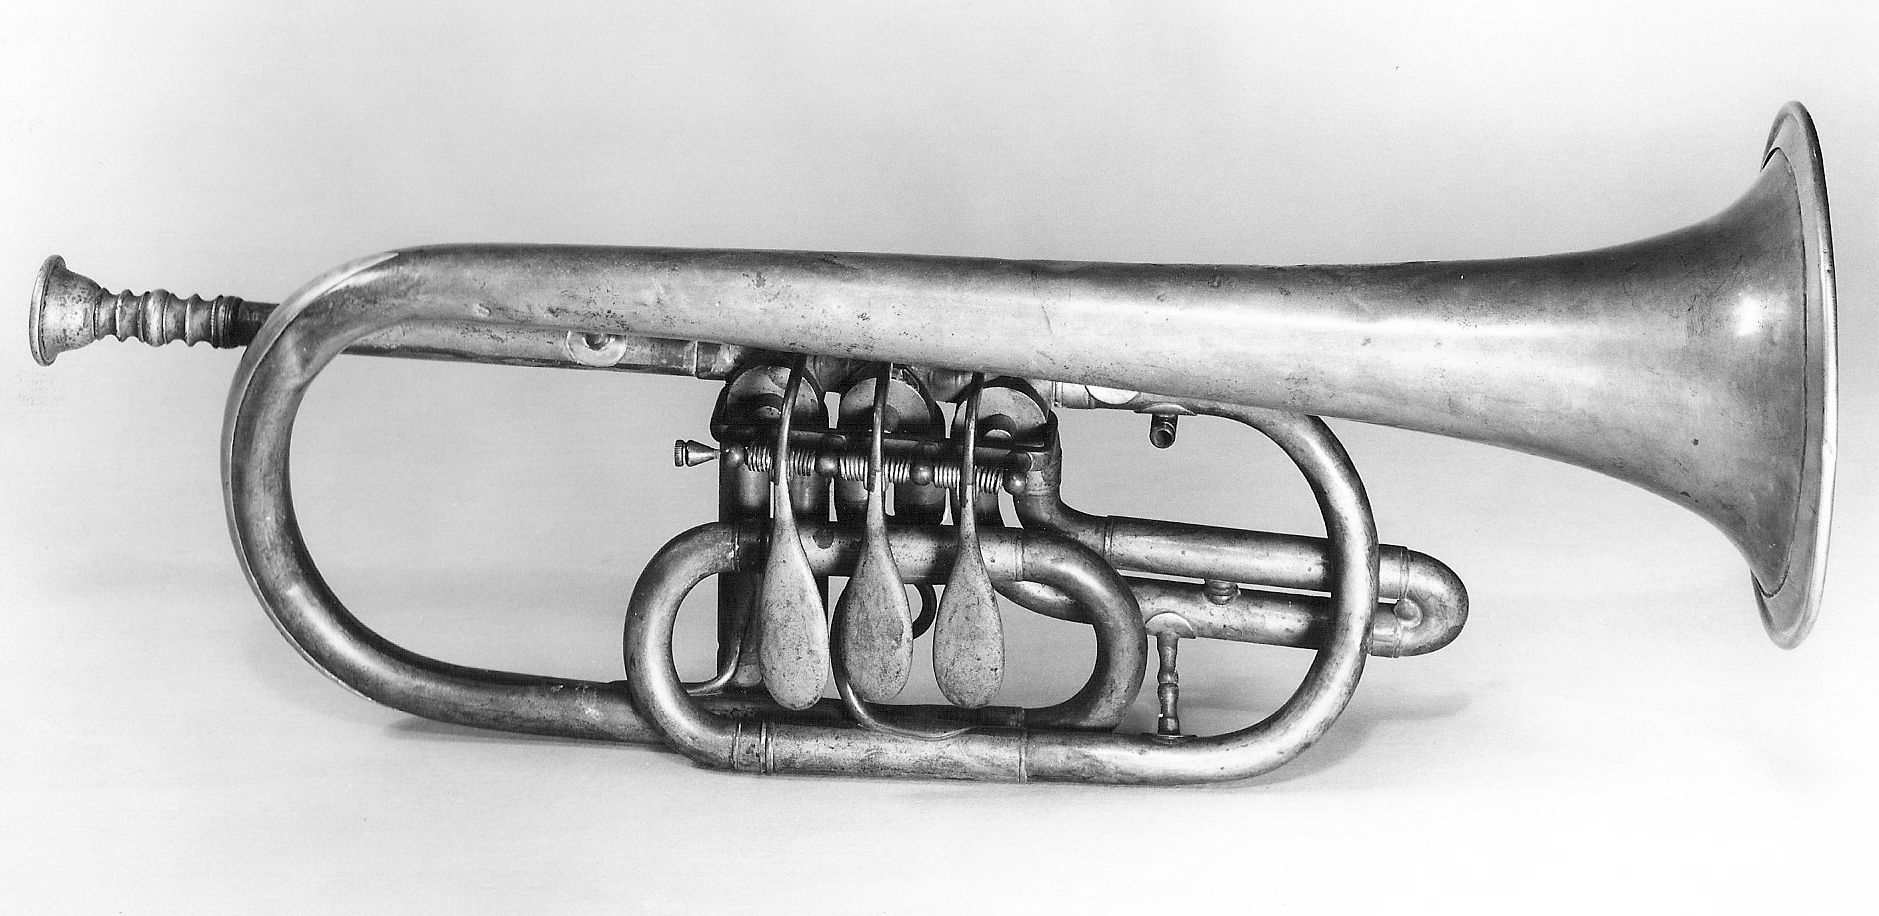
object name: soprano saxhorn in b flat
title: Soprano Saxhorn in B-flat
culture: american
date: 1855-1875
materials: brass, nickel, silver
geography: united states